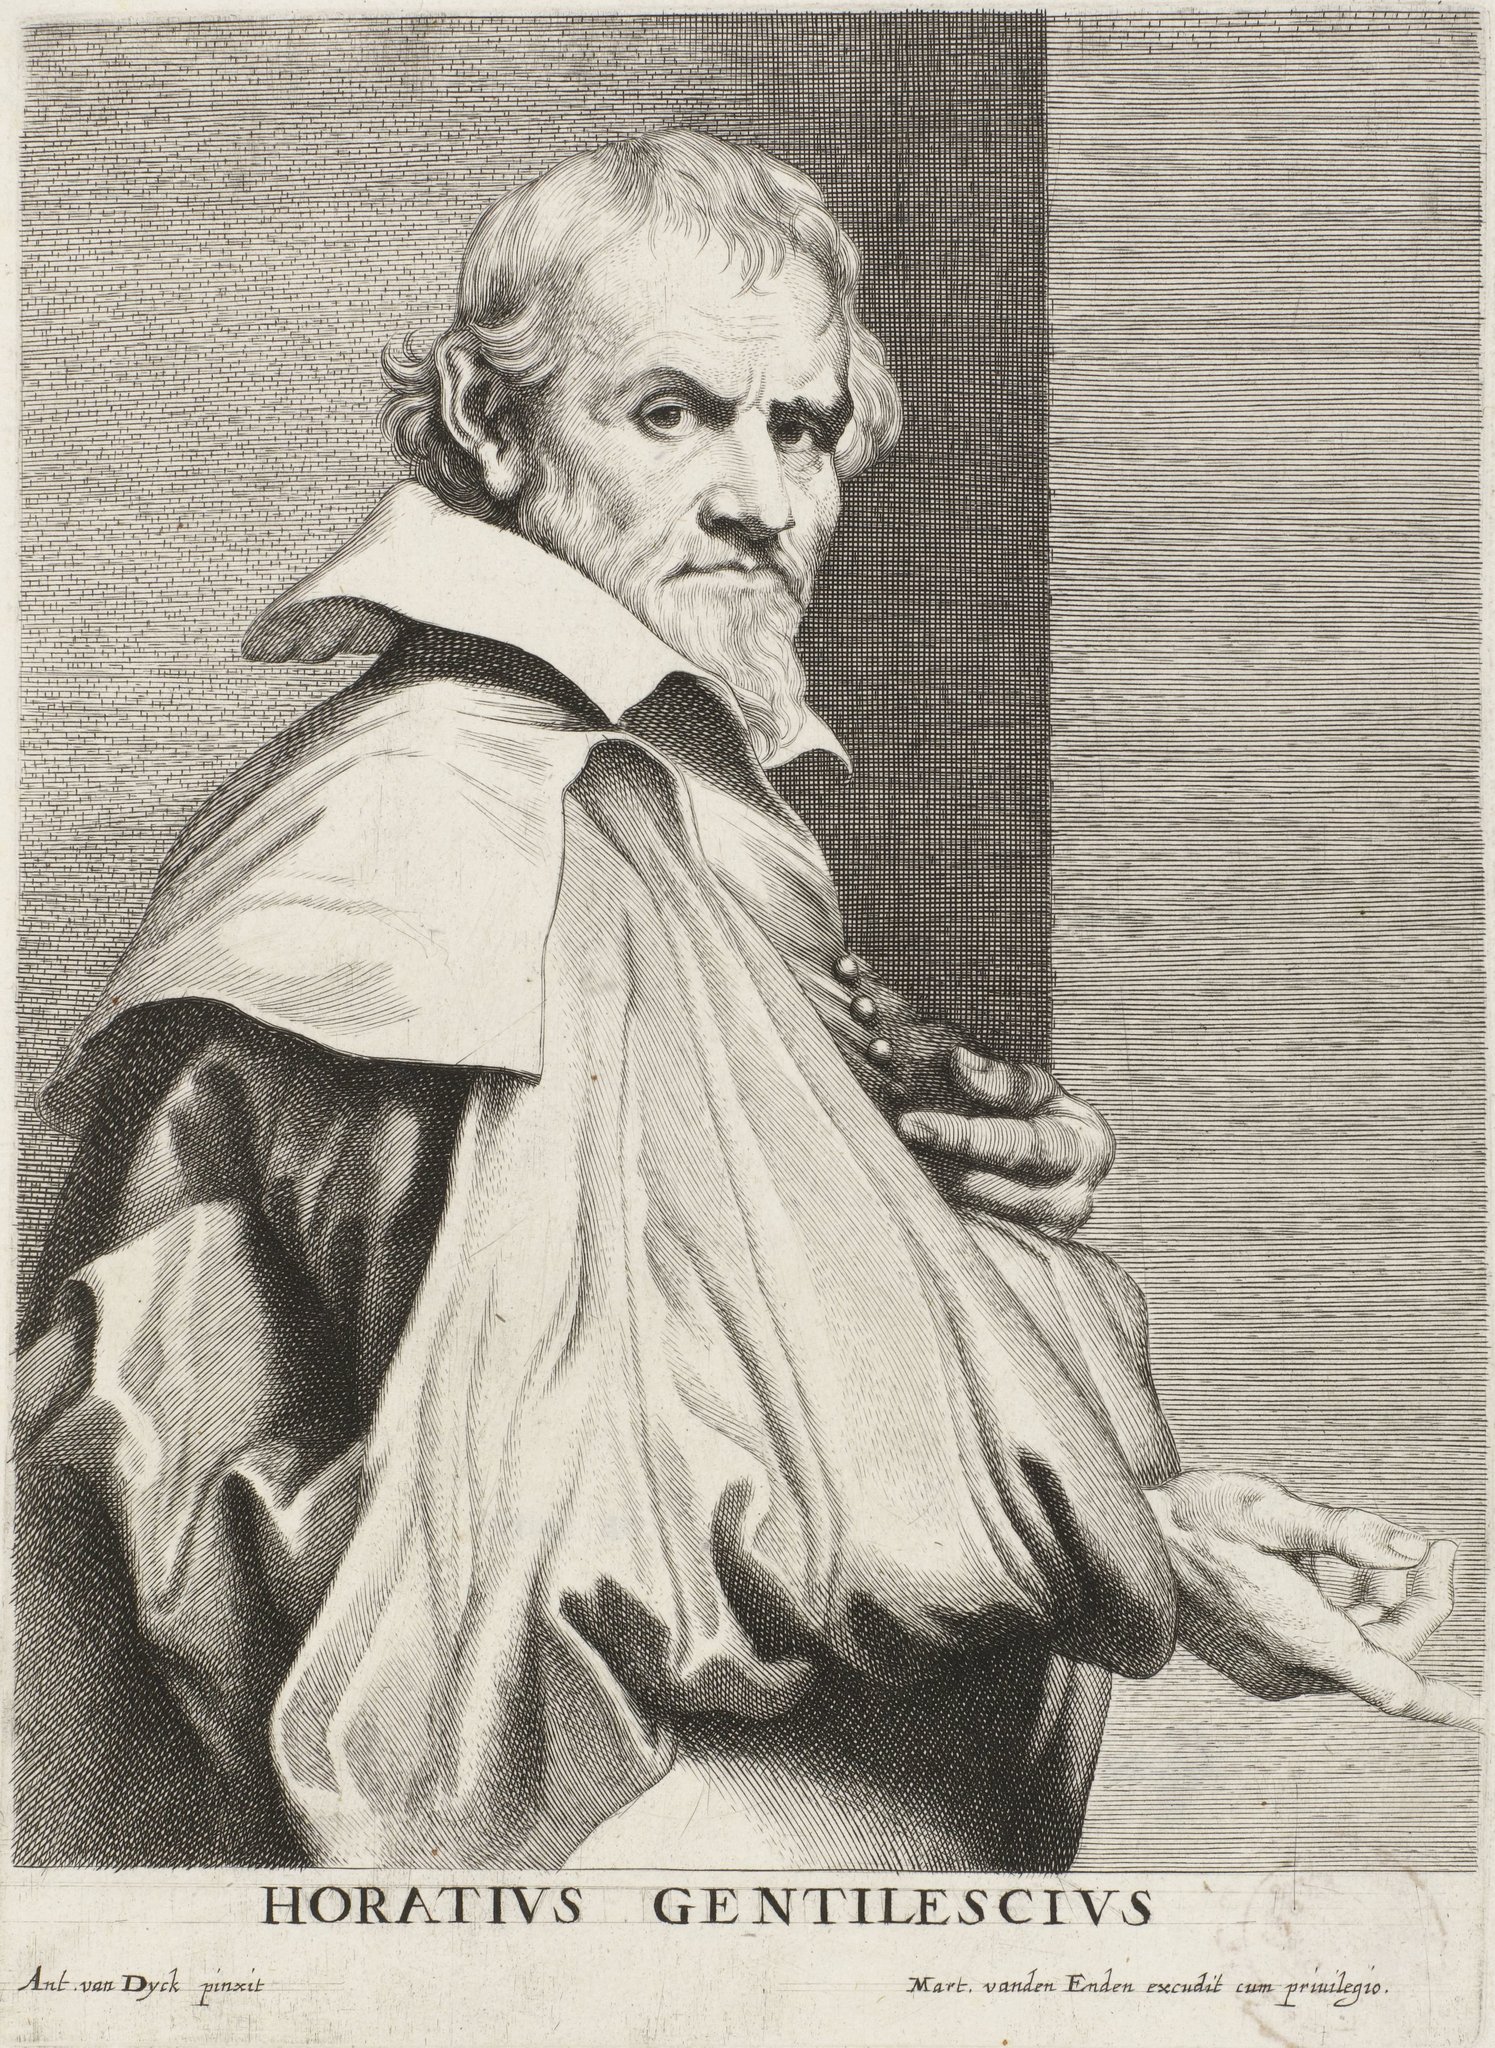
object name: print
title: Portret van Orazio Gentileschi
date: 1630-1646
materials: paper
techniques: engraving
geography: antwerp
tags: london, painter, orazio gentileschi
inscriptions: collector's mark: Lugt 240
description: Prent gebruikt voor: Icones principum, virorum doctorum, pictorum, chalcographorum, statuariorum nec non amatorum pictoriae artis numero centum ab Ant. van Dyck ad vivum expressae ejusque sumptibus aeri incisae. Antwerpen: Gillis Hendricx, [1645-1646].